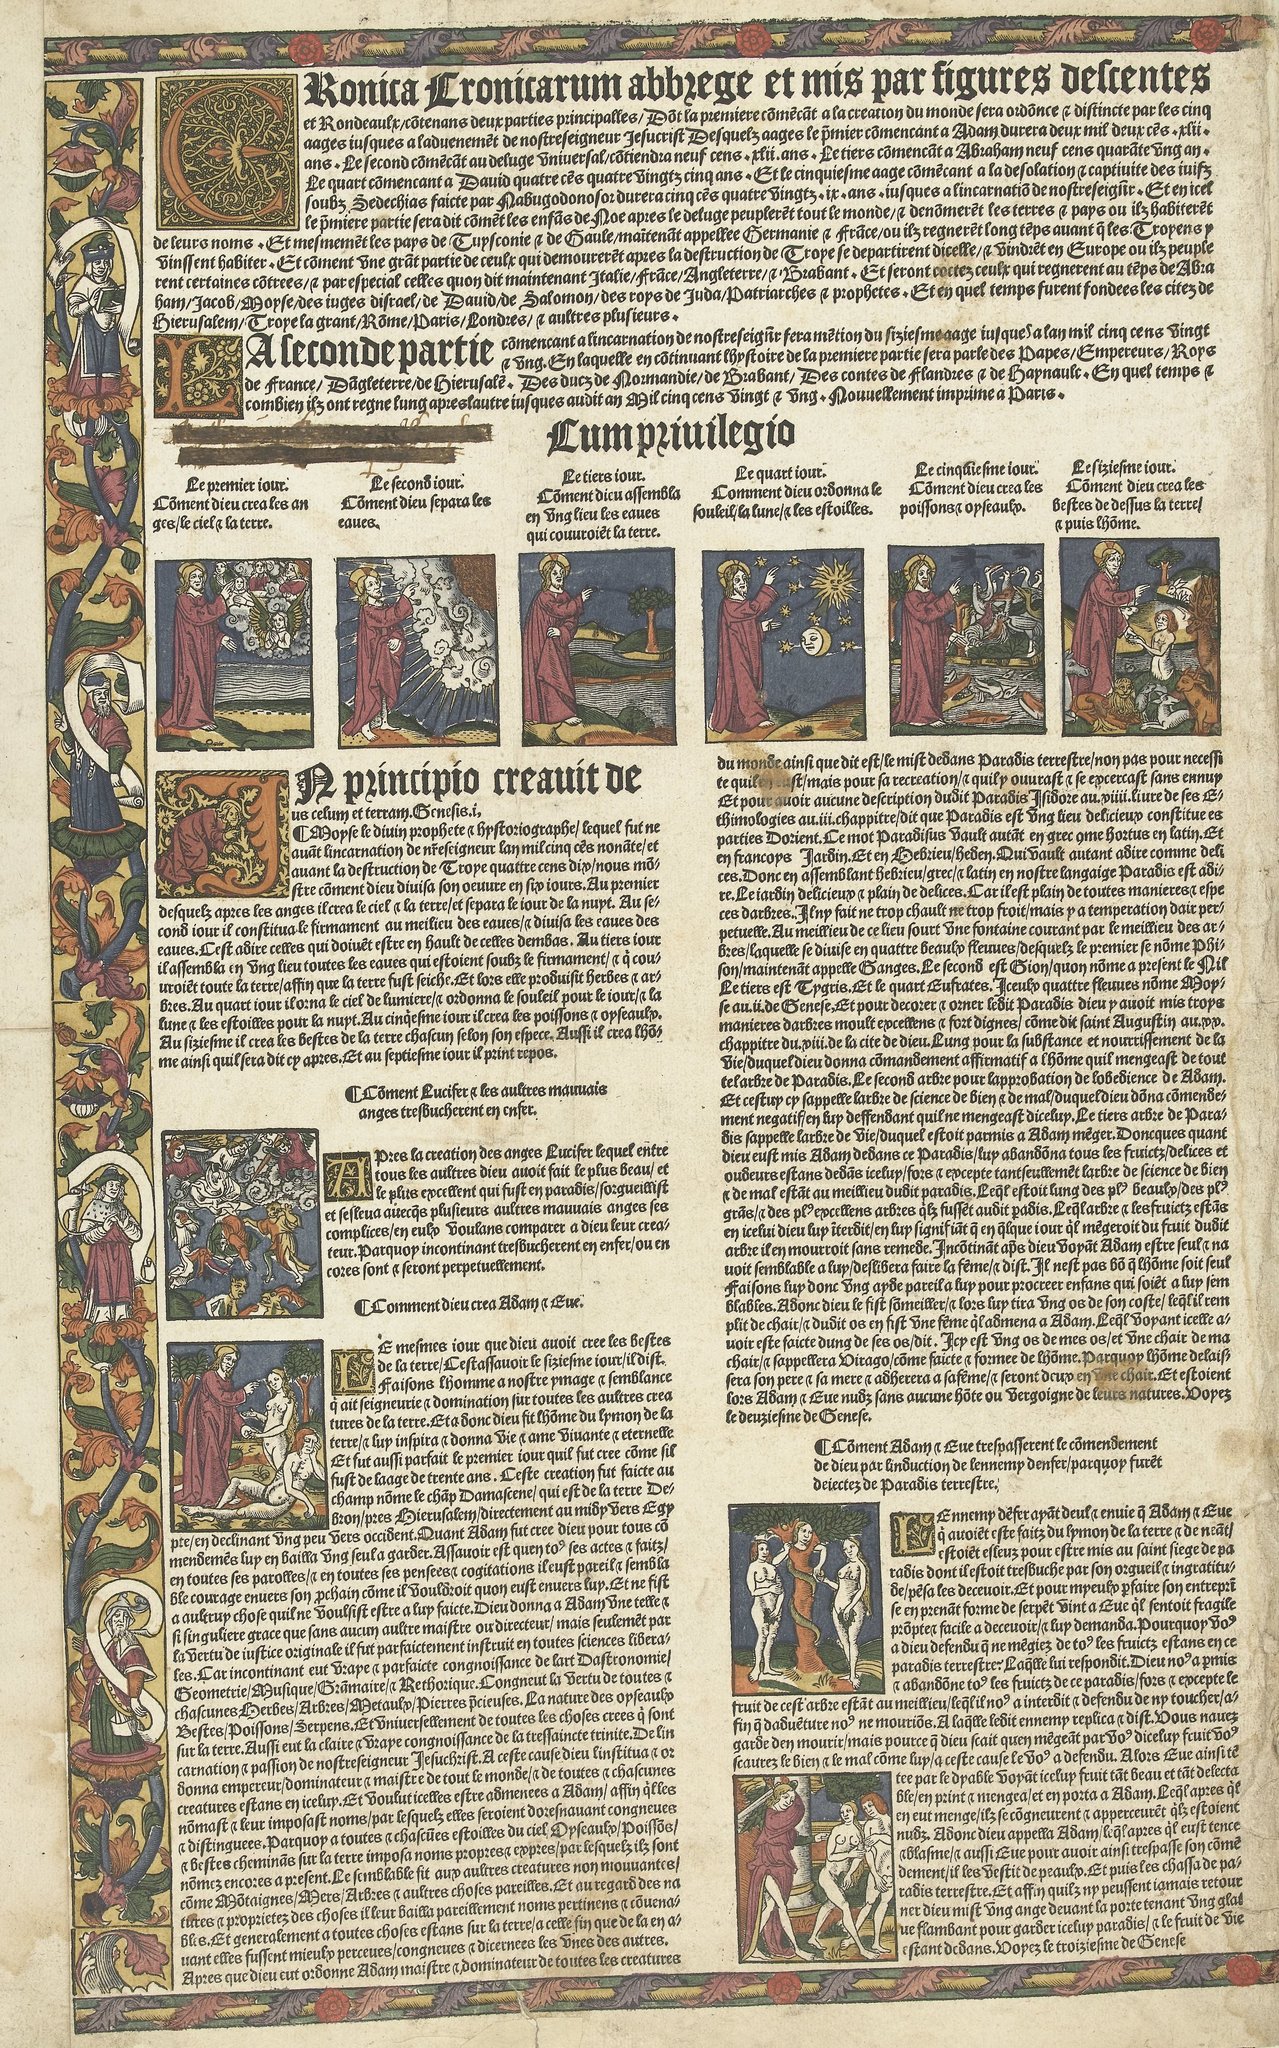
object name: print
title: Cronica Cronicarum (...), blad 1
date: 1521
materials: paper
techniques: hand coloring, letterpress printing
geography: paris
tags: the fall of satan, fall of lucifer, god the creator, eve emerges from adam's body, fall of the rebel angels, who become devils, an angel chases adam and eve out of paradise with a (flaming) sword, eve takes the fruit from the serpent (or the tree) in the presence of adam (who may be trying to stop her), the six days of creation (genesis 1:3-25)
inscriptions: inscription:, collector's mark: Lugt 2760, collector's mark: Lugt 2228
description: Blad 1 verso van een wereldkroniek. Eerste bladzijde van het eerste deel. Tekst in boekdruk in het Frans met versierde initialen. Bovenaan zes voorstellingen naast elkaar van de zes scheppingsdagen. Links onder het midden een voorstelling van de val van Lucifer (Satan). Daaronder een voorstelling van de schepping van Eva uit de zij van Adam door God de Vader. Rechtsonder twee voorstellingen. Boven: de zondeval. Onder: Adam en Eva verdreven uit het paradijs. Geheel links een ornamentrand met profeten.